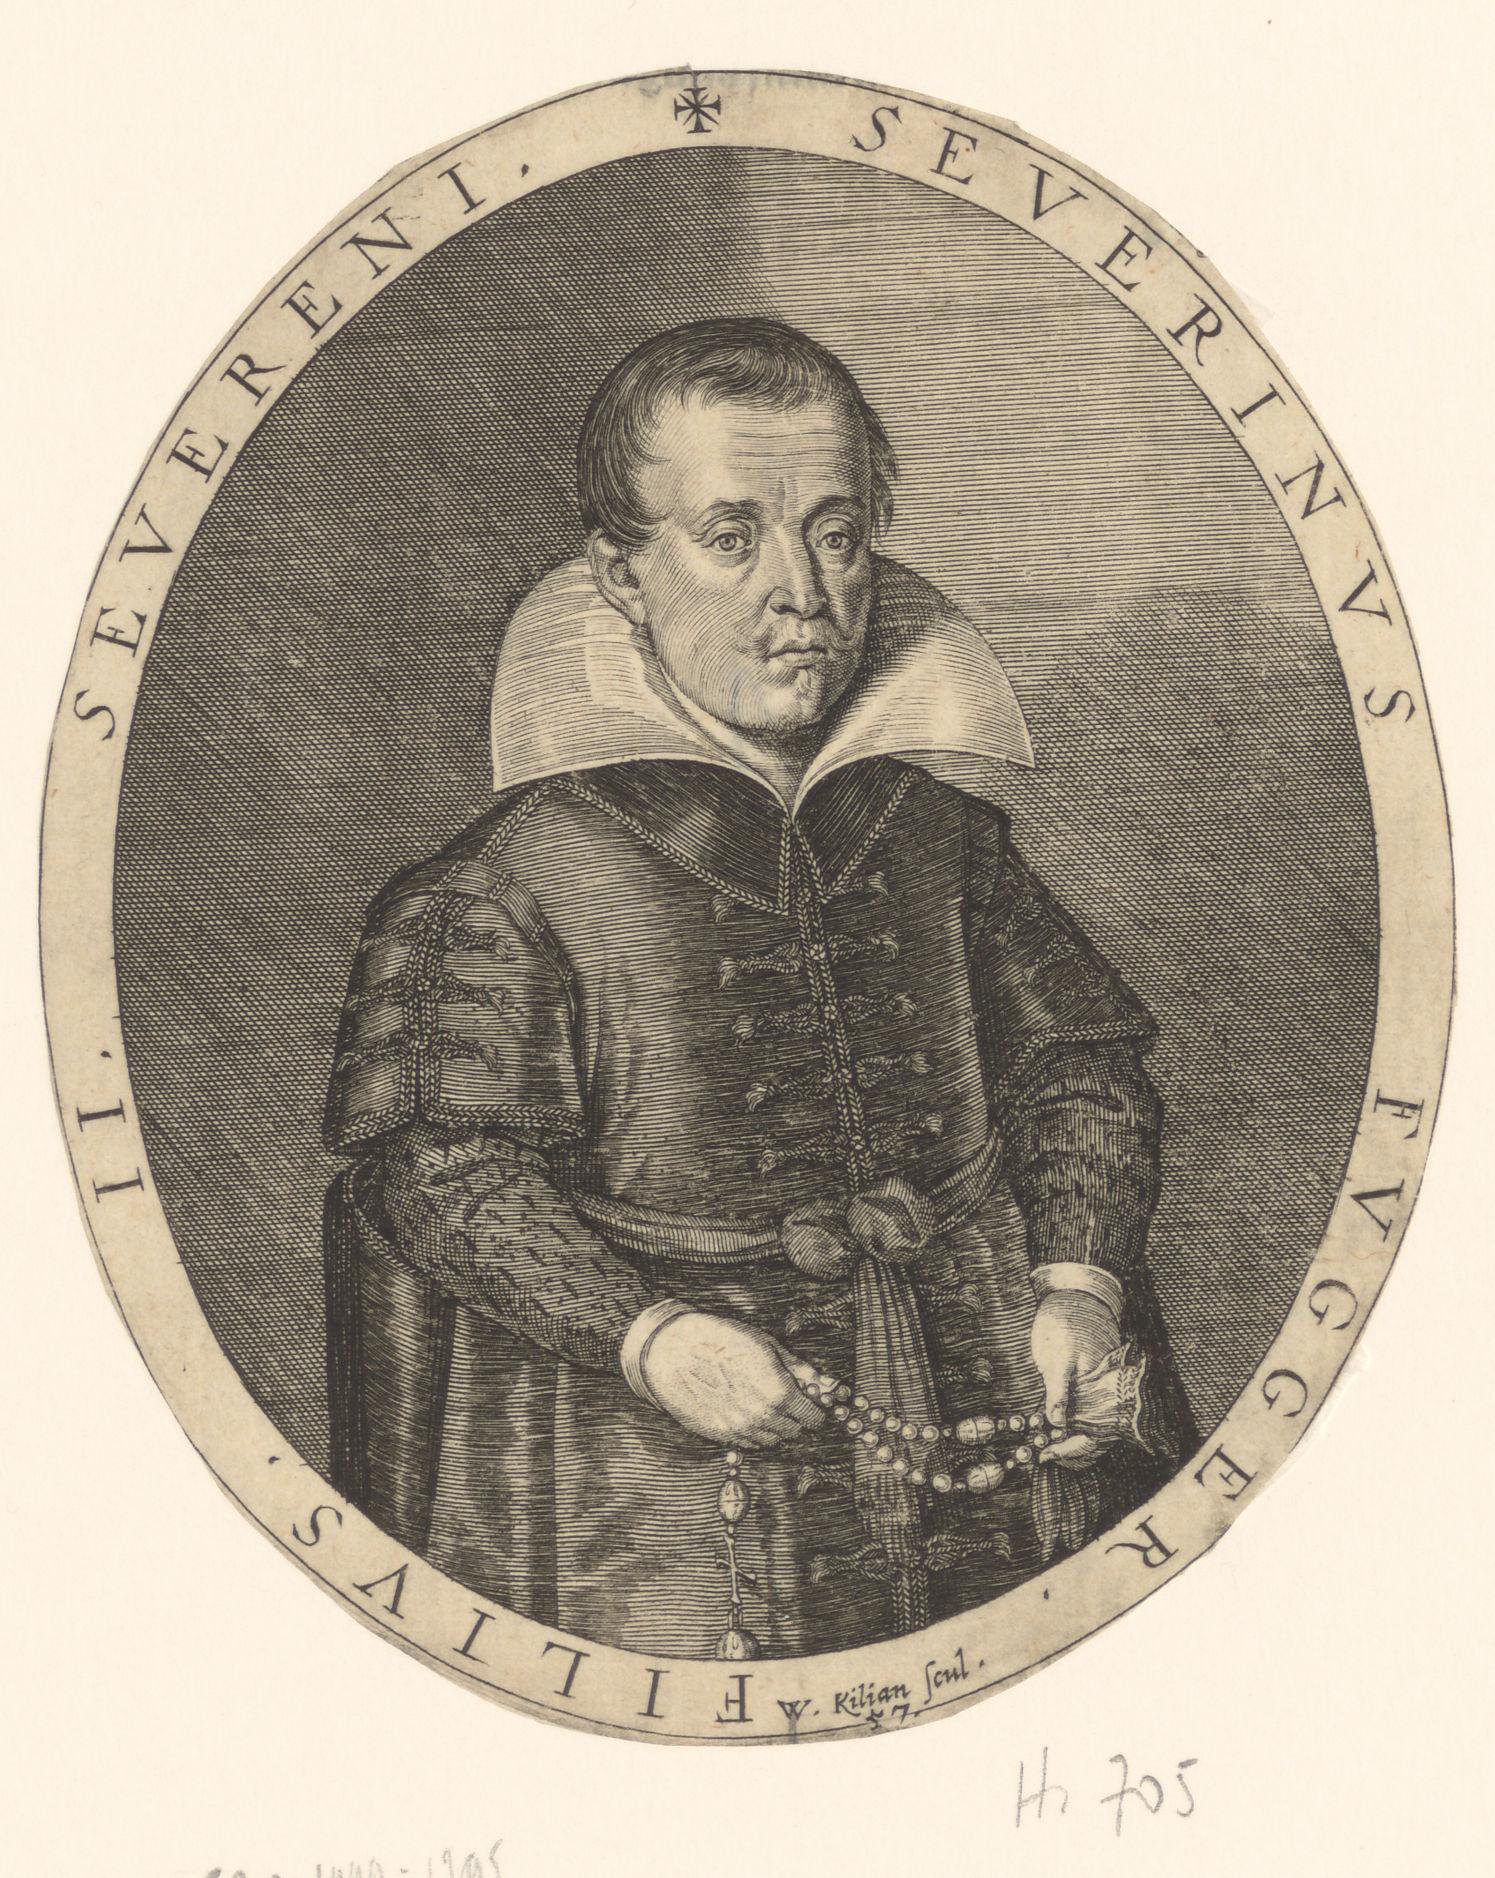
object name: print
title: Portret van Severin Fugger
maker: wolfgang kilian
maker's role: print maker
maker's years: 1581-1662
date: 1596-1620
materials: paper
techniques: engraving, etching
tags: historical persons, regent, substitute ruler; viceroy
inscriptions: collector's mark: Lugt 2228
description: Hollstein German suggereert dat deze prent mogelijk gebruikt is in: Kilian, Lucas en Kilian, Wolfgang. Contrafehe Der Herrn Fugger und Frawen Fuggerin (...) welche in diesen Geslechte geboren wurden, und zu demselben sich ehelich verplichtet haben (...) Anno MDCXX. Augsburg: Wolfgang Kilian, 1620.